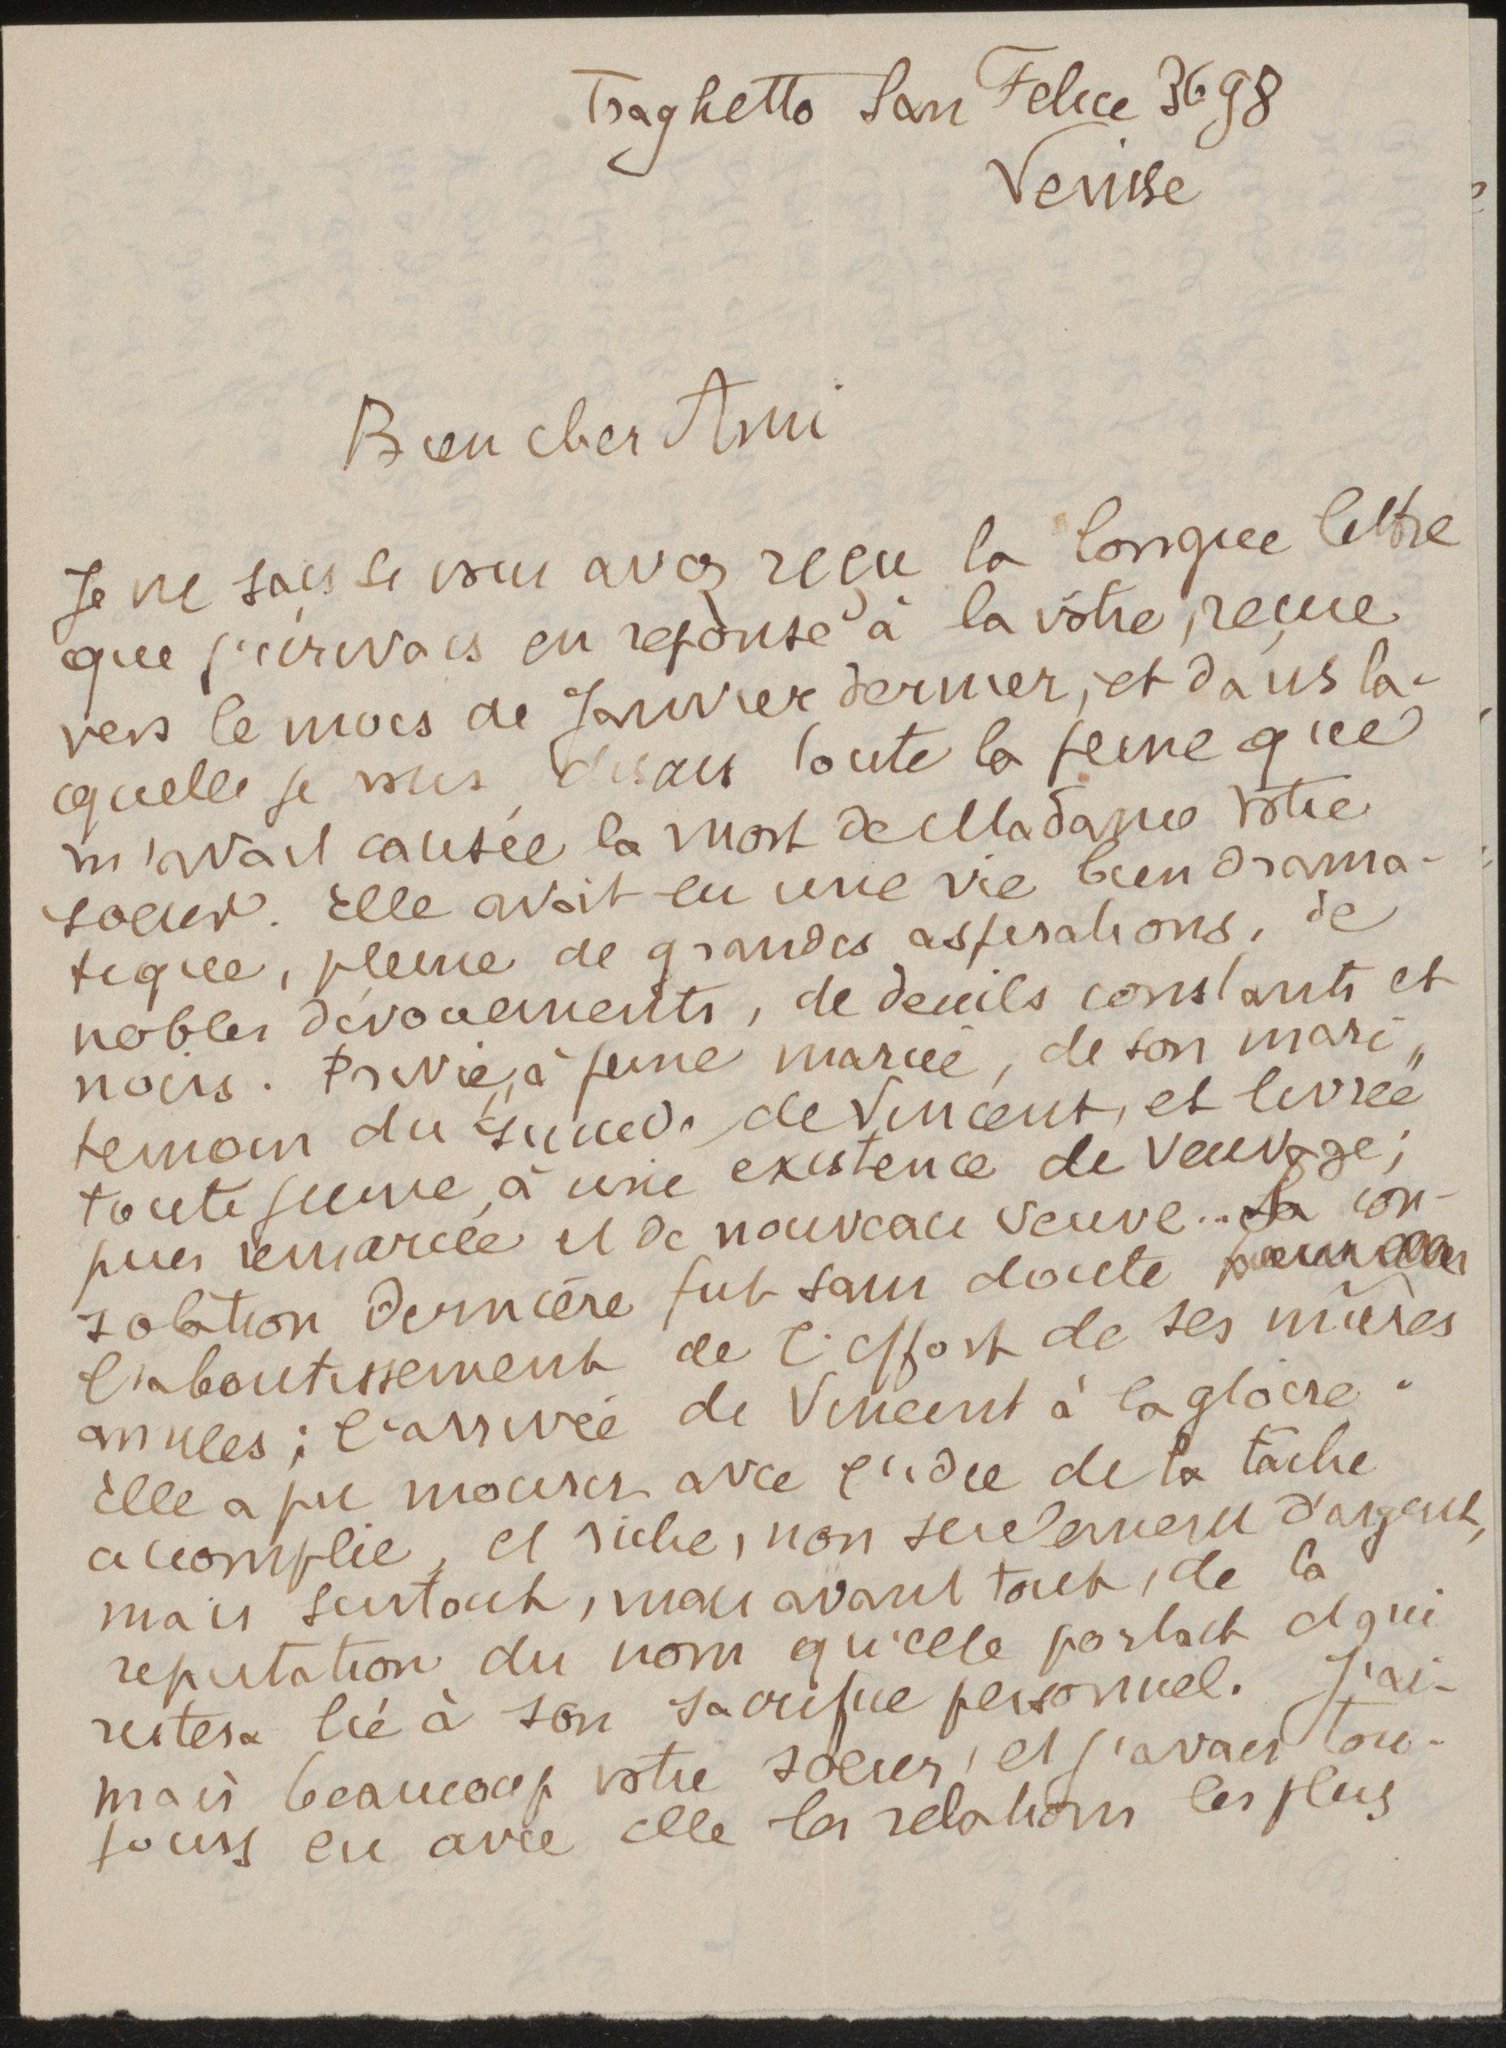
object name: letter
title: Brief aan Andries Bonger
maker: émile bernard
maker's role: print maker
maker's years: 1868-1941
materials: ink, paper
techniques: pen, writing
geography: venice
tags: painter, draughtsman, vincent van gogh, andries bonger, naples, vittorio pica, amsterdam, johanna bonger, passions, emotions, affections, family life, painting (including book-illumination, miniature-painting), exhibition ~ art, art collecting, money, paris, venice, lyon